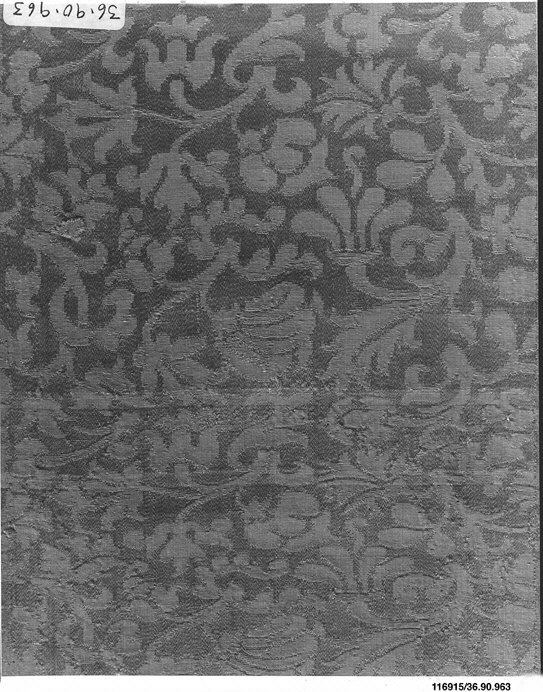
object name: piece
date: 1601-1700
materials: silk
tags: flowers,leaves